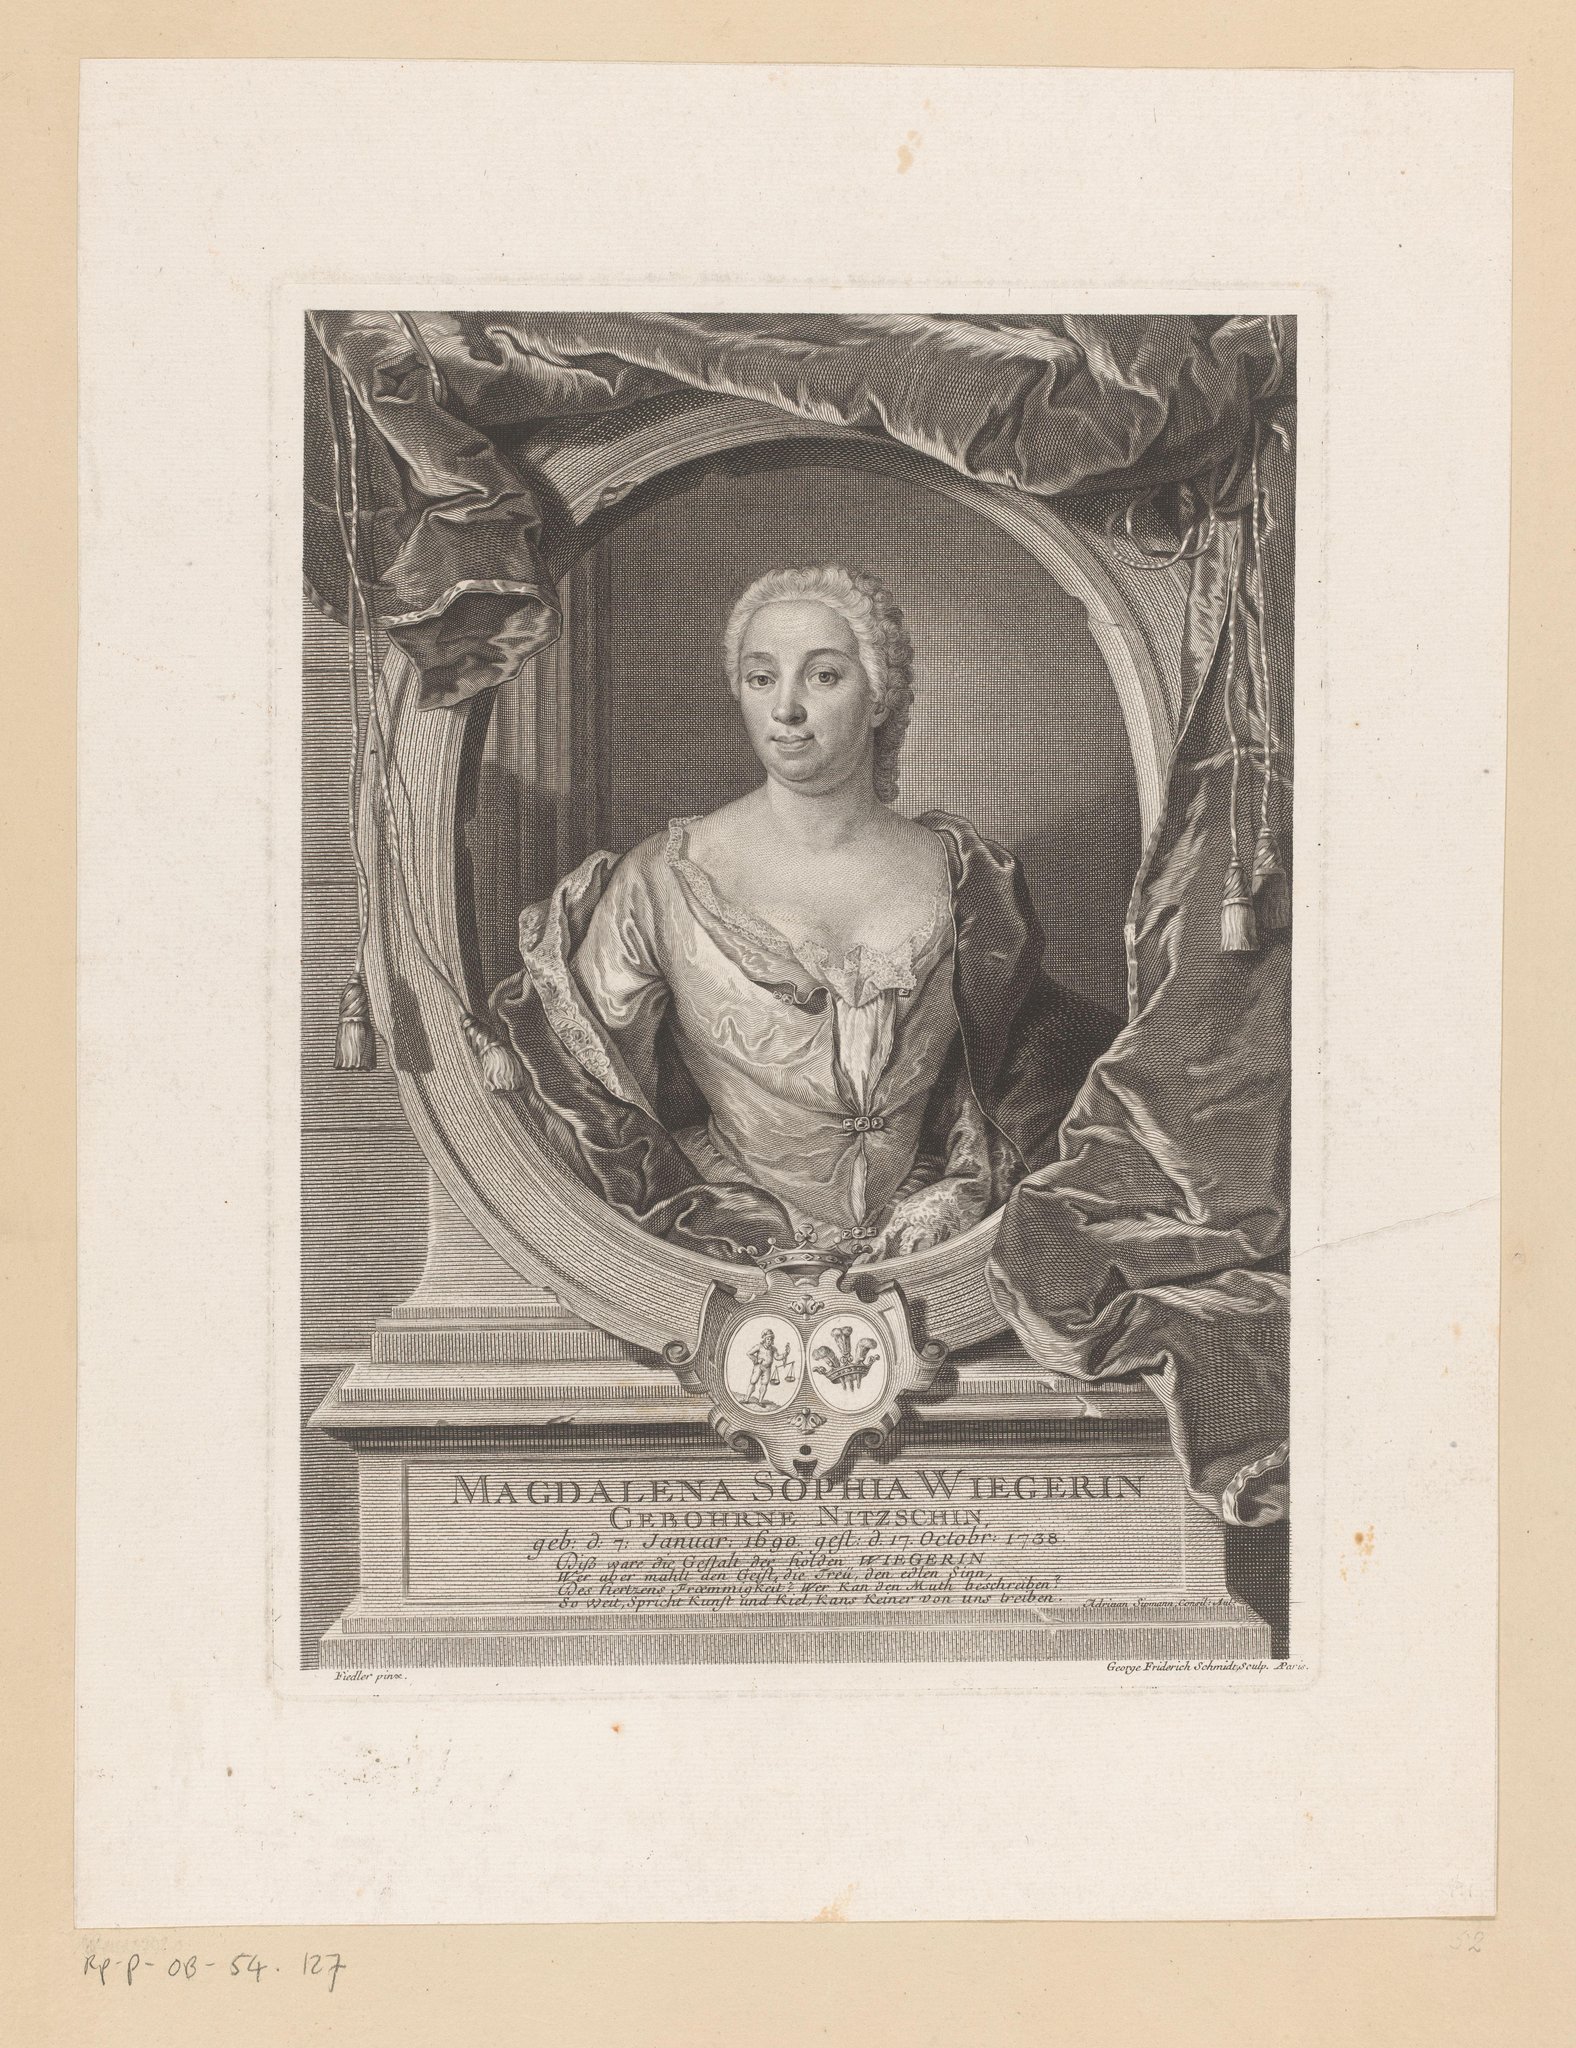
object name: print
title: Portret van Magdalena Sophia Wieger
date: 1738-1775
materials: paper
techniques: engraving, etching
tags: historical persons - bb - woman, armorial bearing, heraldry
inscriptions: collector's mark: Lugt 240